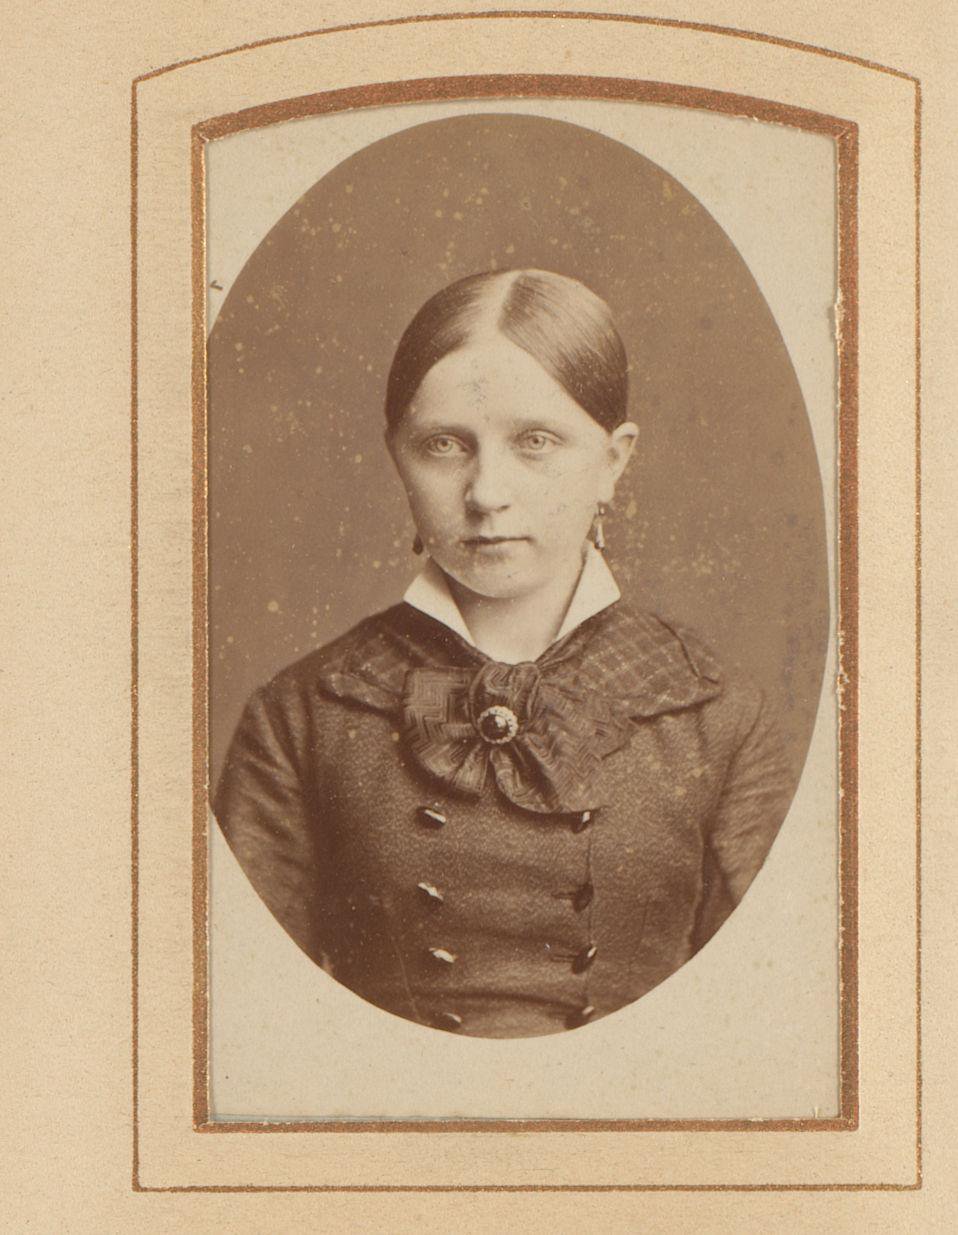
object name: album leaf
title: Portret van een meisje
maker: Anonymous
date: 1870-1900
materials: cardboard, photographic support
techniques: albumen print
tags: historical persons - bb - woman, girl (child between toddler and youth)